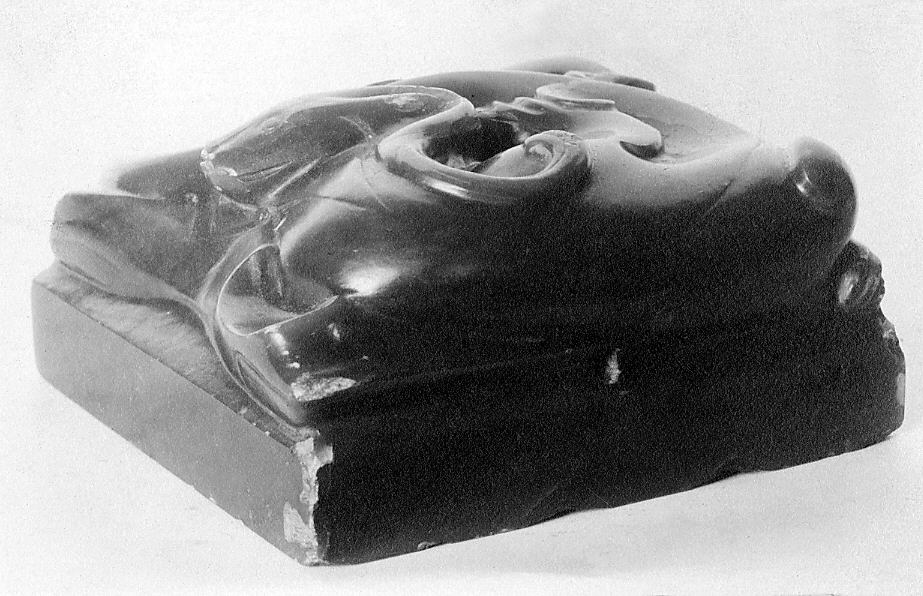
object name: seal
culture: chinese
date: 960-1279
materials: jade